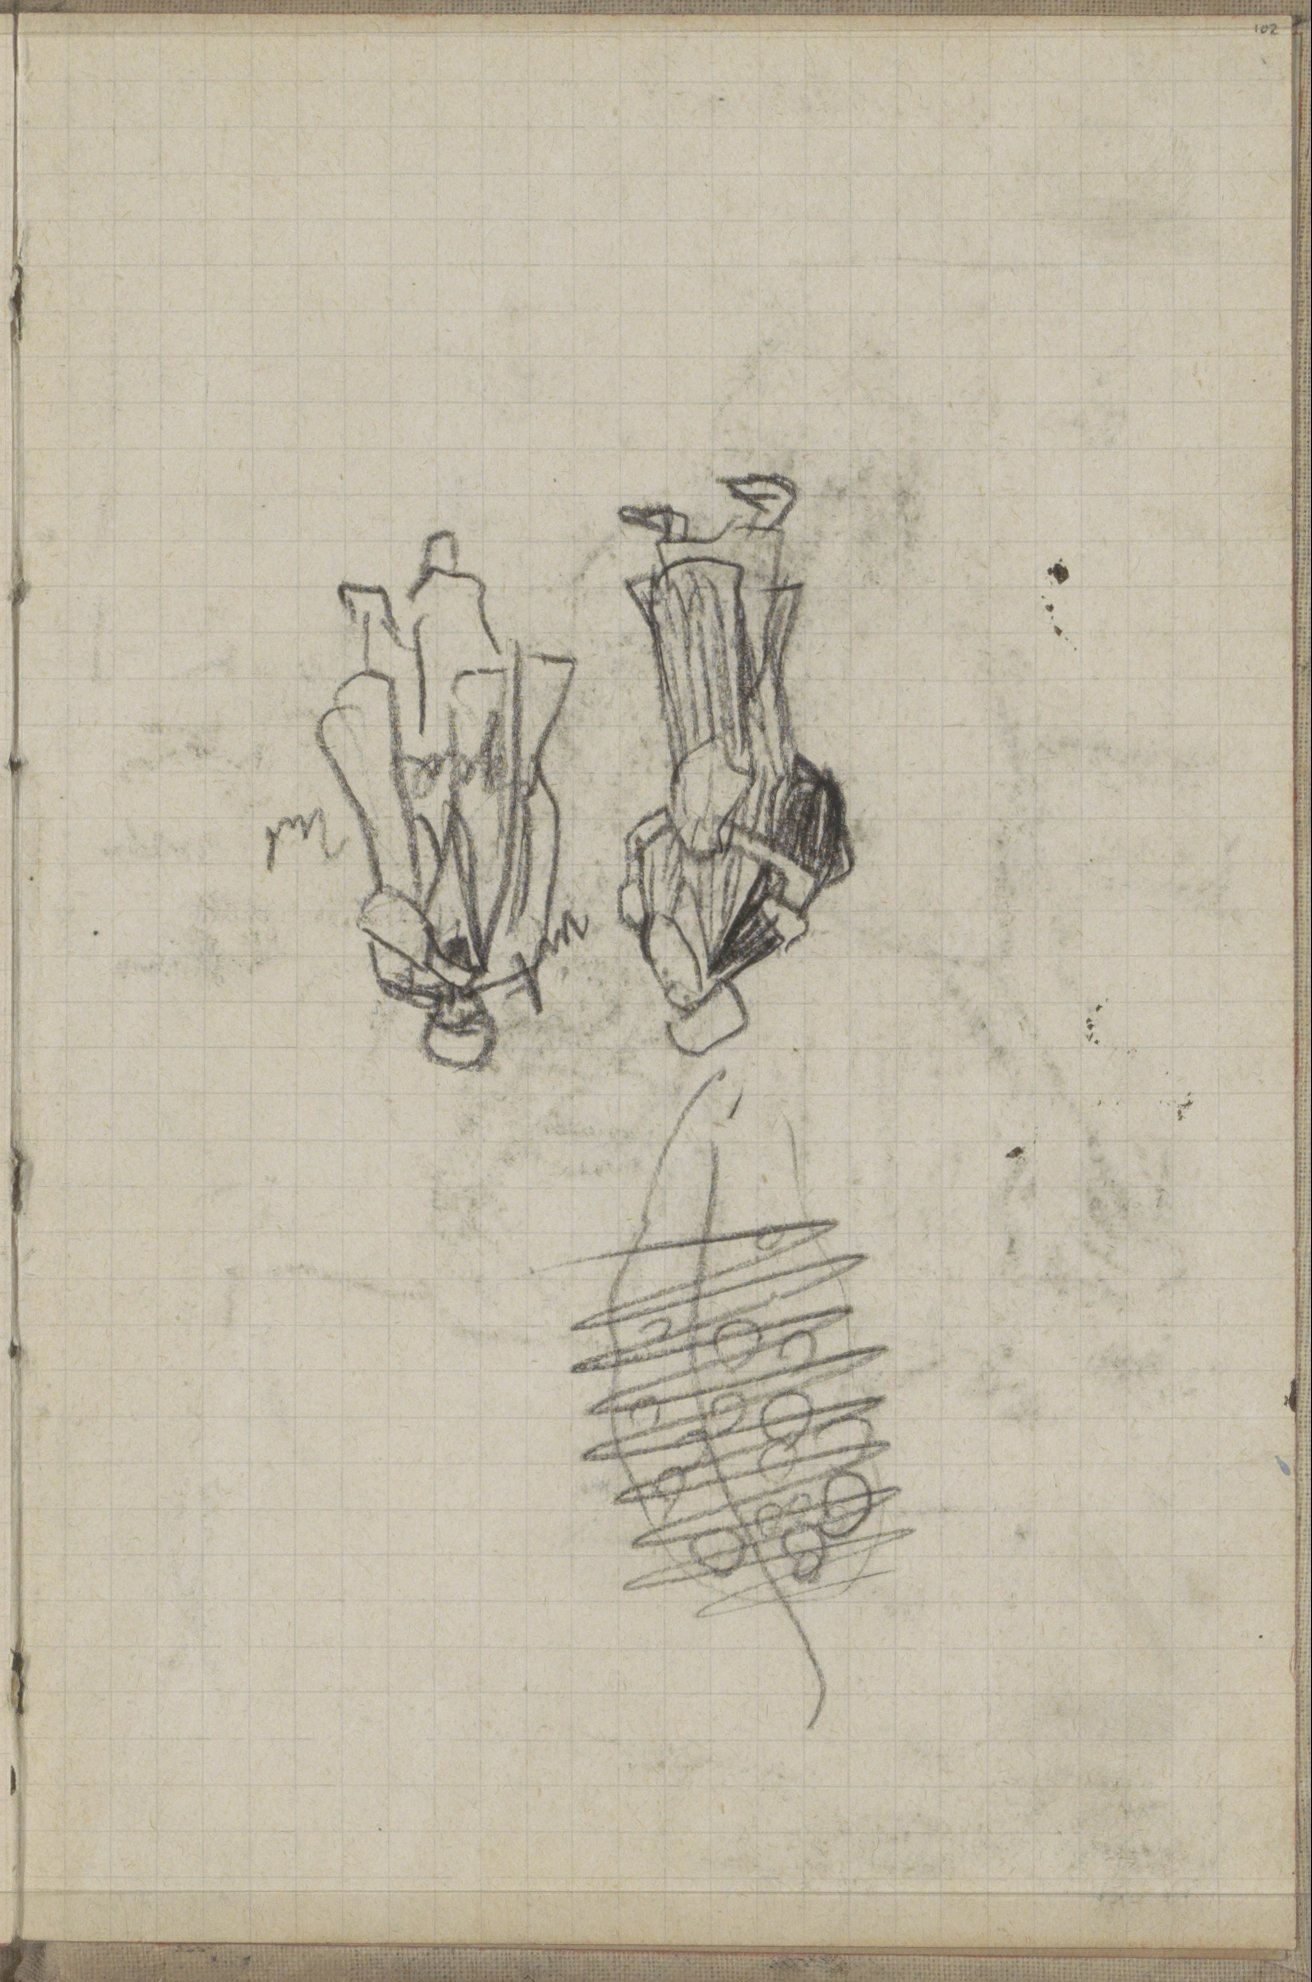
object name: sketchbook leaf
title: Twee figuren in oosterse kleding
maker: marius bauer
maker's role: draughtsman, print maker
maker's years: 1867-1932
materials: chalk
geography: istanbul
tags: asiatic races and peoples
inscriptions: kleurnotitie, handgeschreven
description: Pagina 102 uit een schetsboek met 51 bladen.